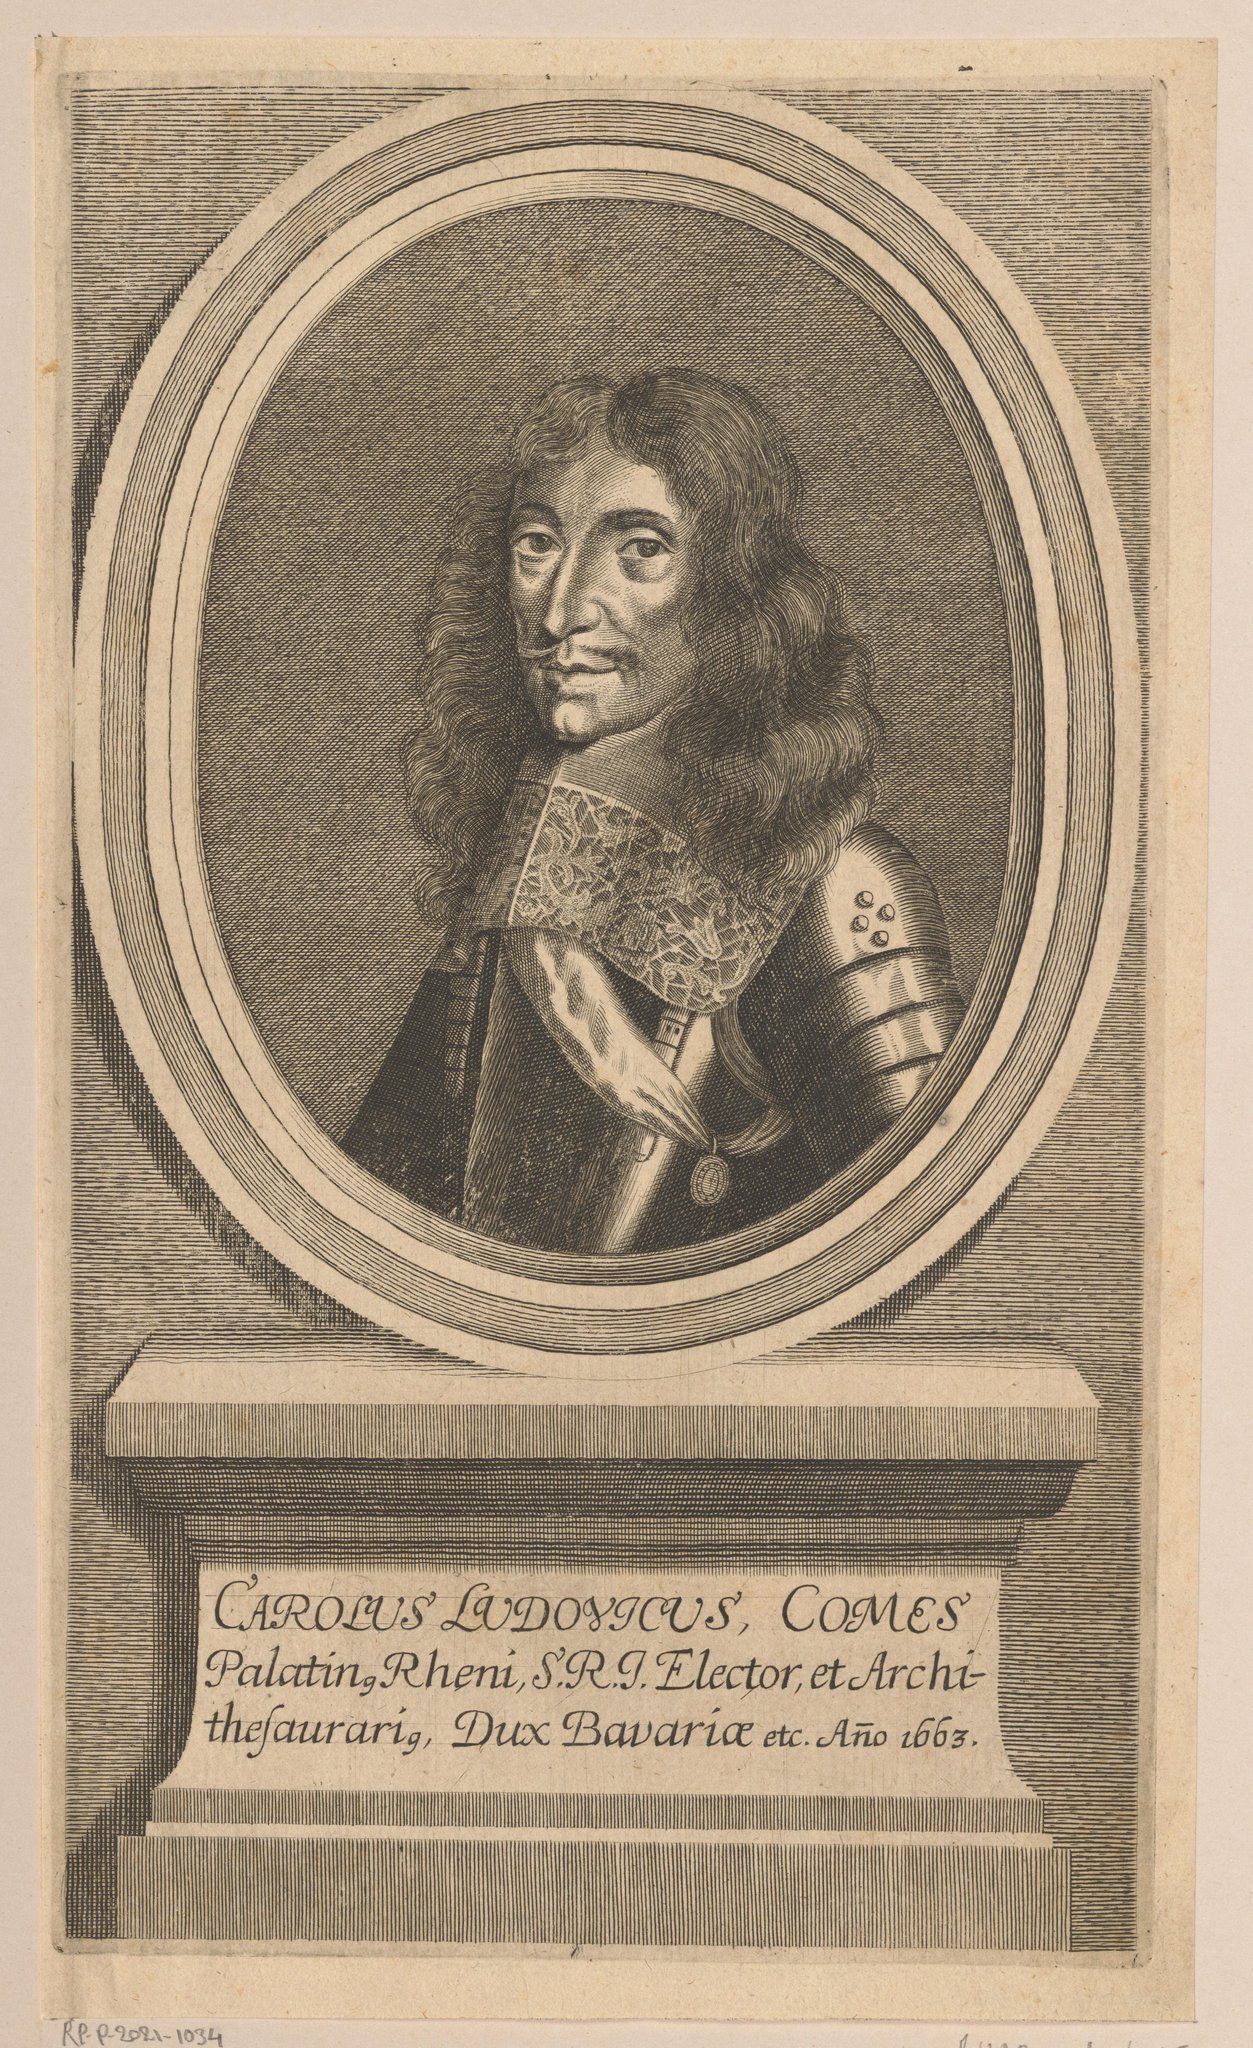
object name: print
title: Portret van Karel Lodewijk, keurvorst van de Palts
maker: Anonymous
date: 1692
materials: paper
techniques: engraving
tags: historical persons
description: Prent mogelijk uit: Happel, Eberhard Werner. Historia Moderna Europae (...). Leipzig: Matthäus Wagner, 1692.